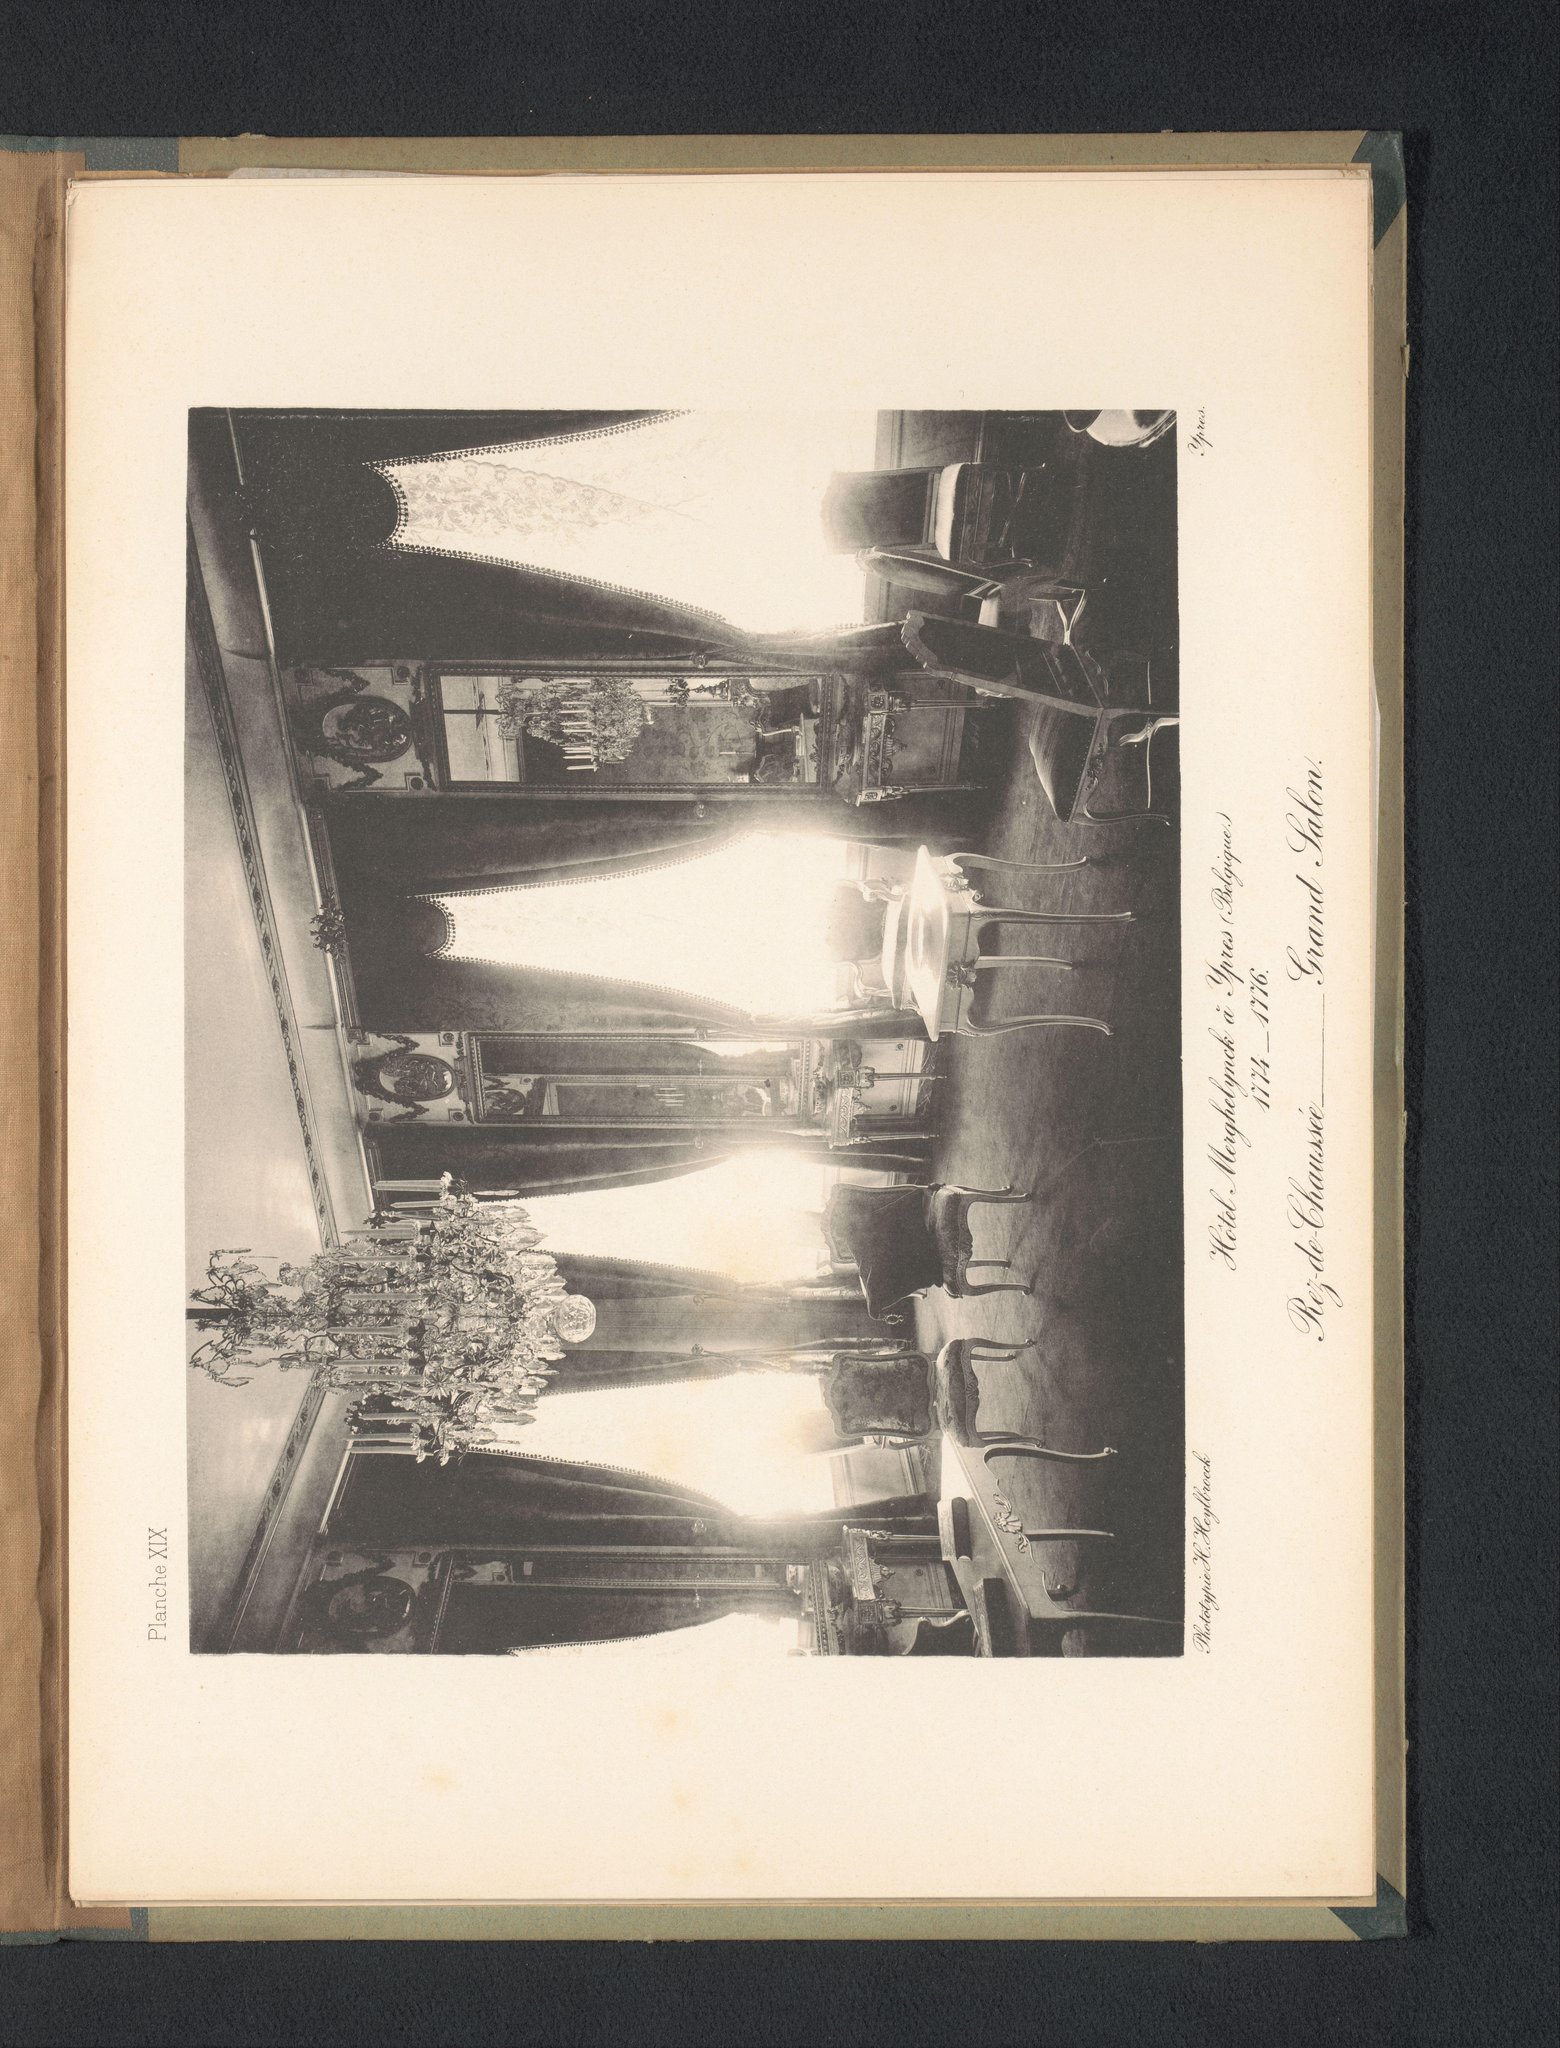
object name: photomechanical print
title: Rez-de-Chaussée - Grand Salon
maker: hector heylbroeck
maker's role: fotograaf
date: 1889-1894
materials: paper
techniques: photograph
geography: ieper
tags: living-room, parlour, sitting-room, hotel, hostelry, inn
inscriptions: number: ‘Planche XIX’, inscription: ‘Ypres.’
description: Deze prent maakt deel uit van een omslag met 31 prenten en een katern met teksten.